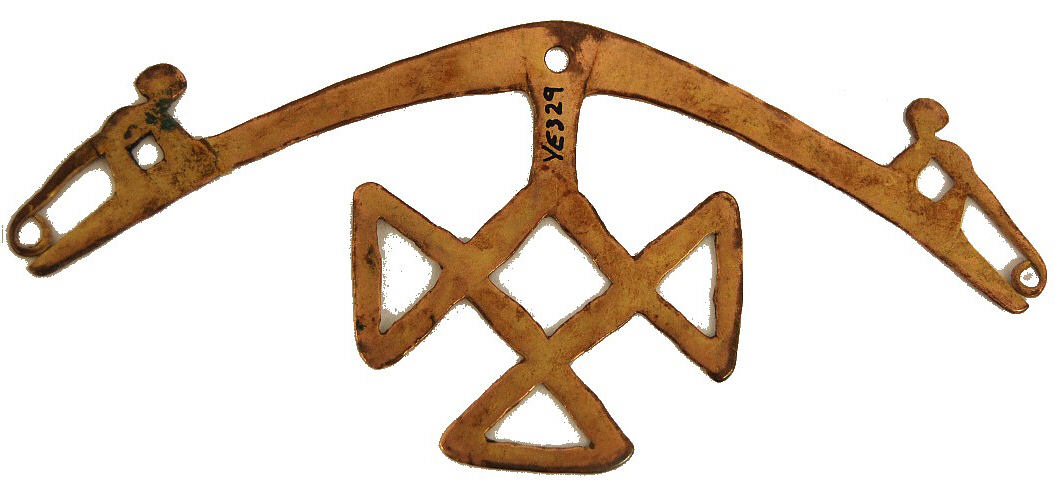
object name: pendant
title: Monkey Pendant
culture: carchi-nariño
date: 800-1500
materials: gold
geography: ecuador or colombia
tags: monkeys